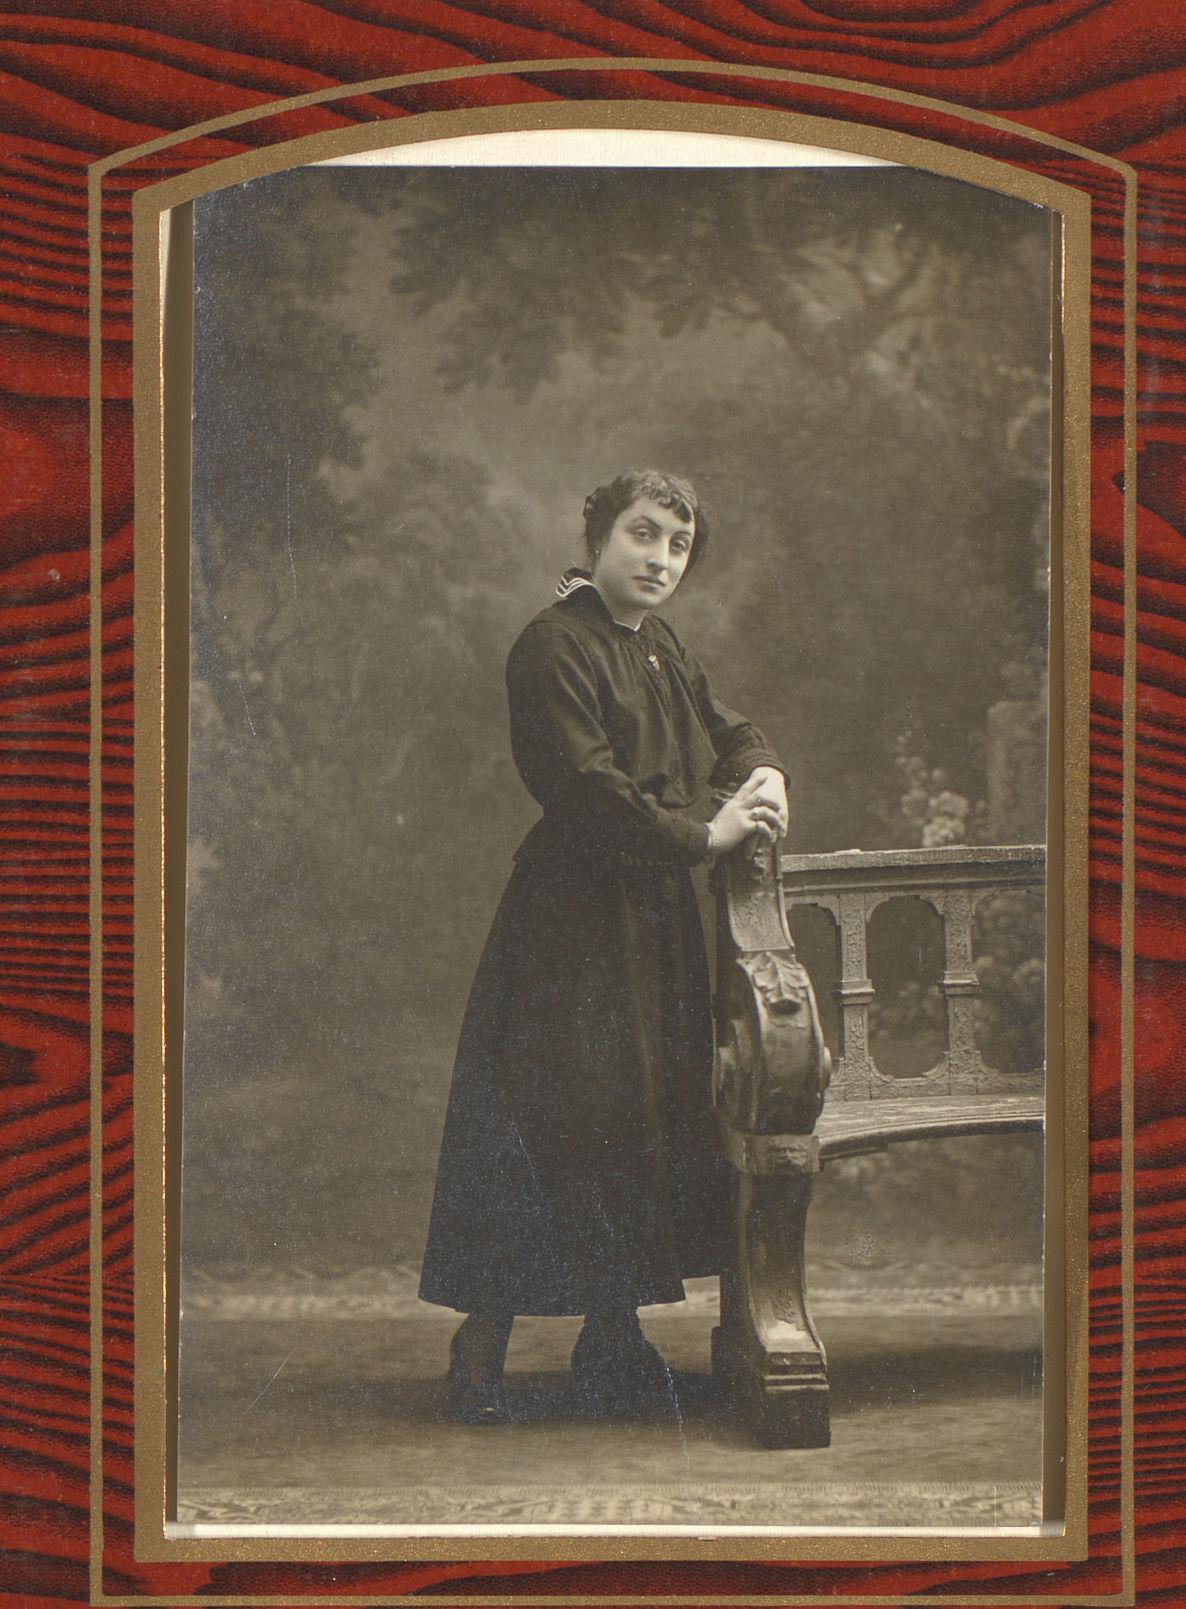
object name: photograph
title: Portret van een vrouw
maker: fontis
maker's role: publisher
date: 1880-1930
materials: photographic support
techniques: gelatin silver print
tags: adult woman, historical persons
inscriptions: annotation: ‘Huge embrasse beau/ Marie & Geo’